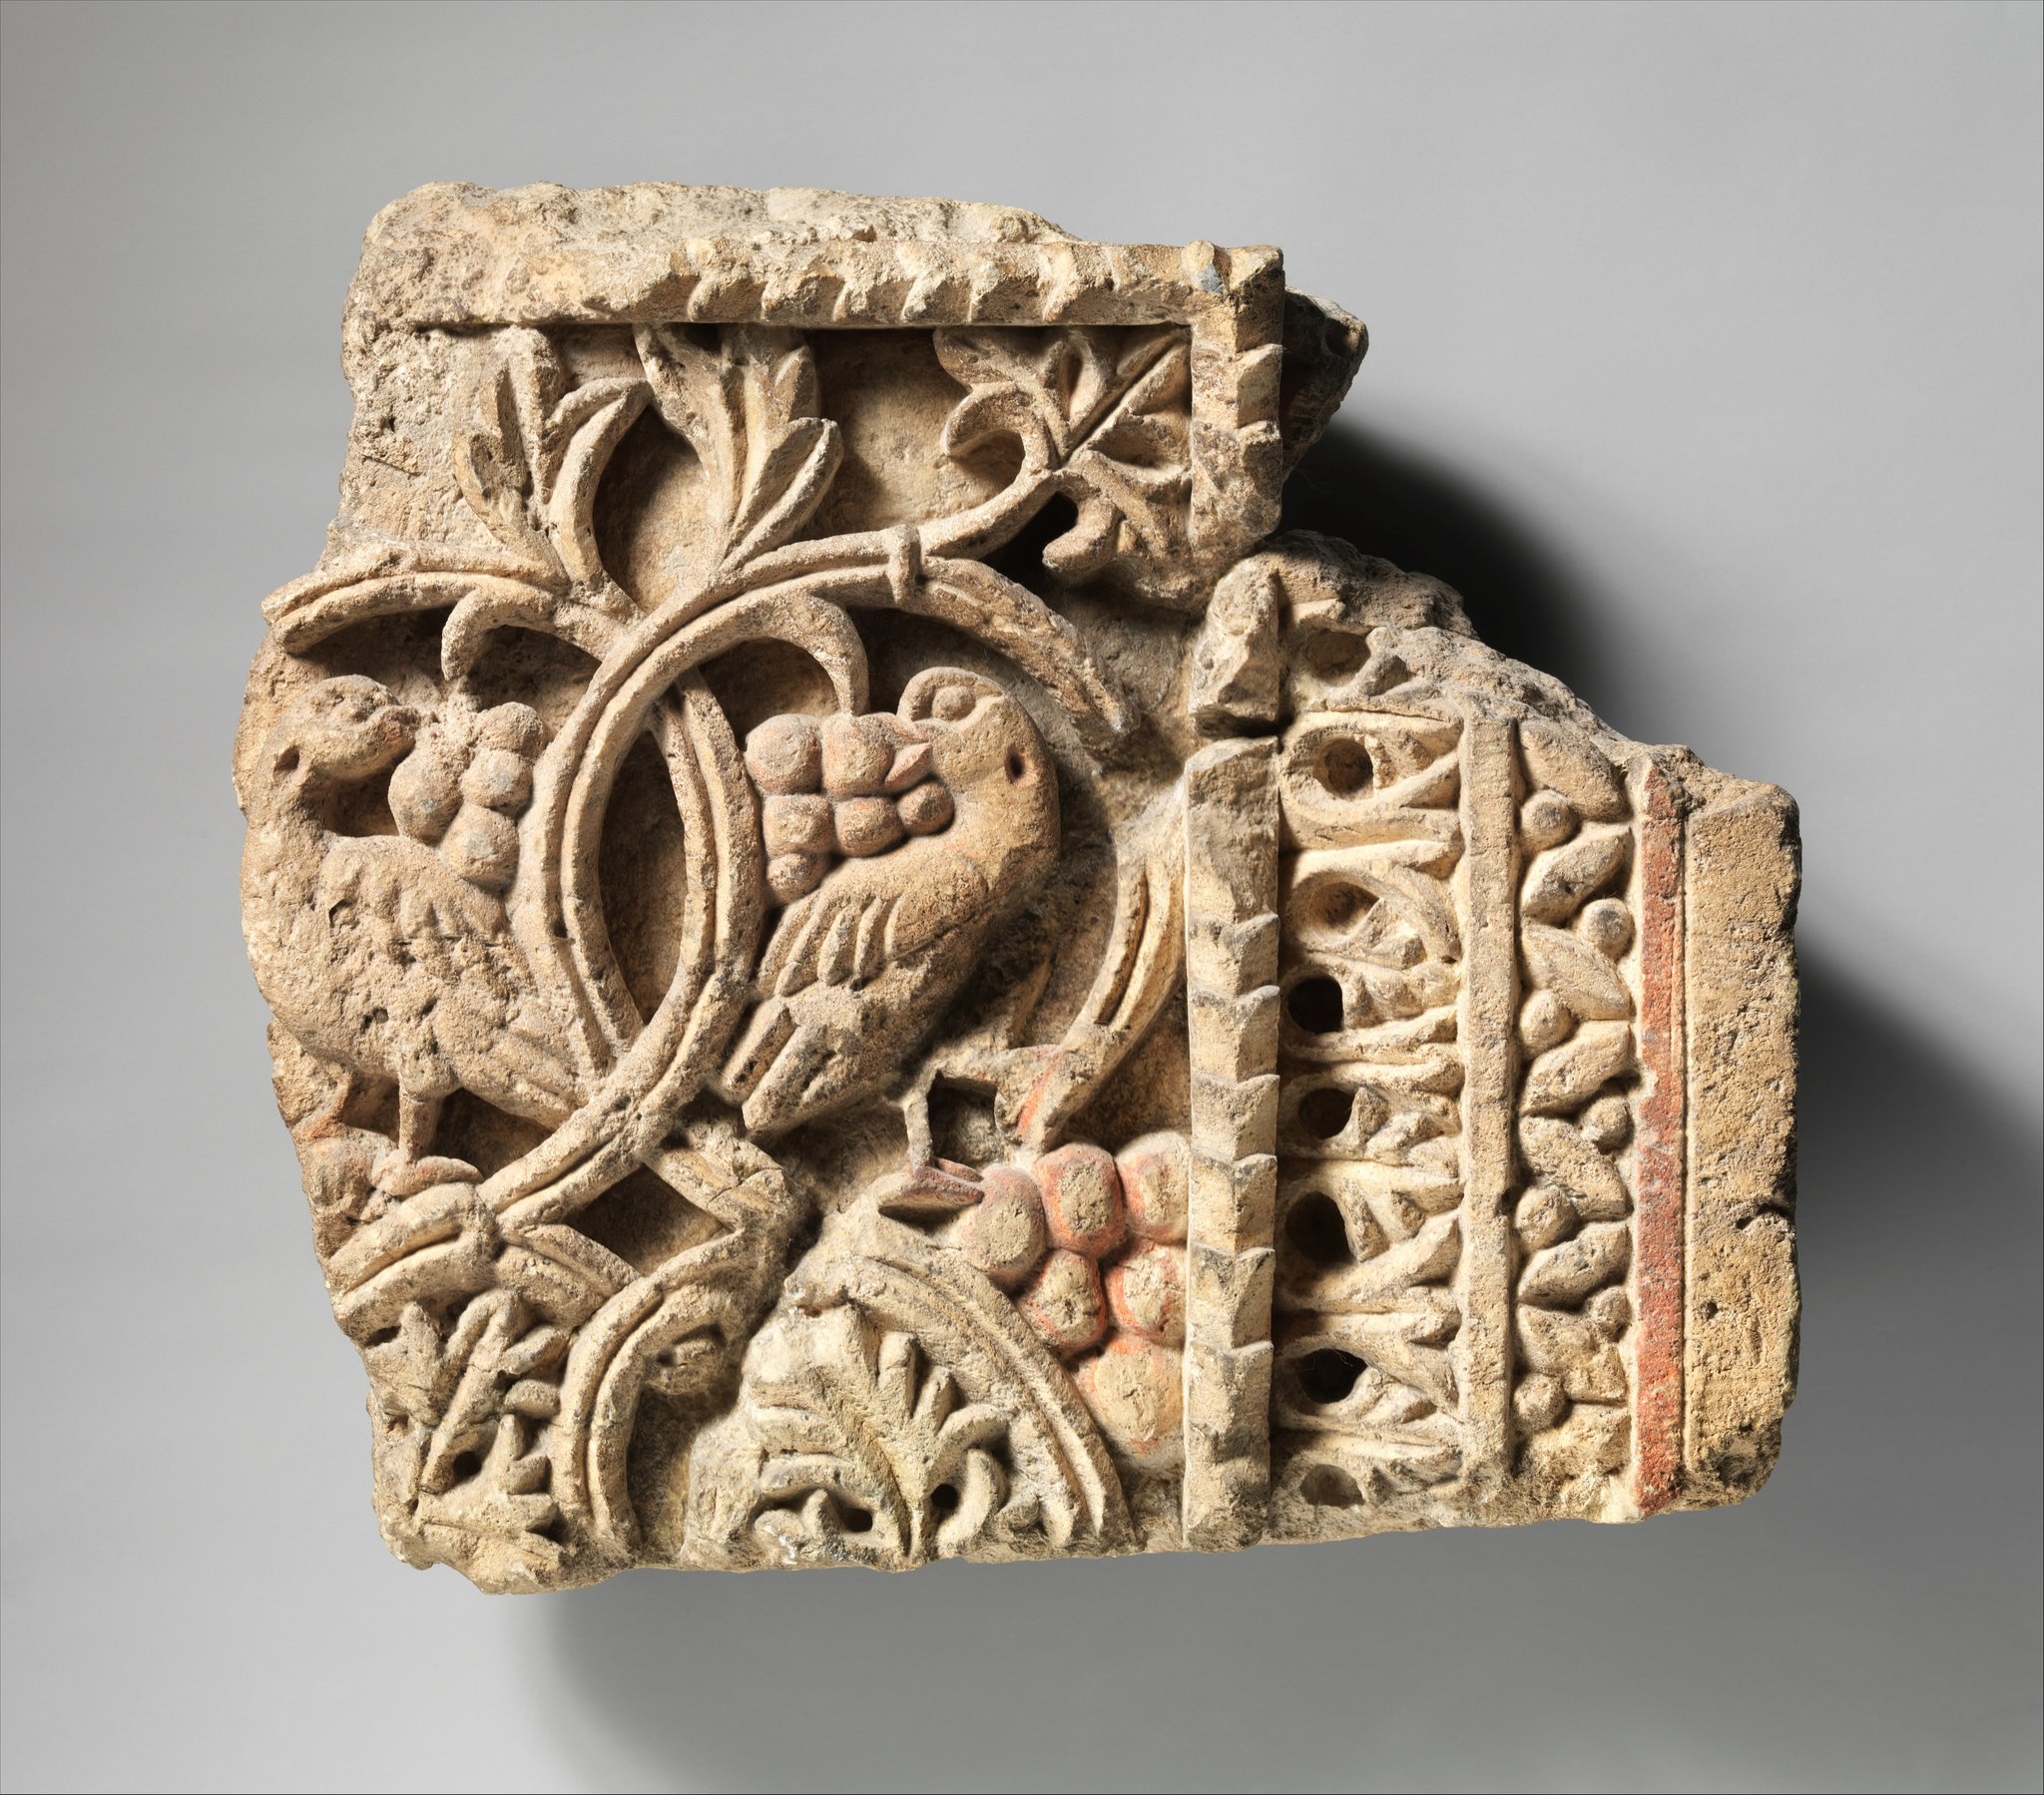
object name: screen fragment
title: Fragment from a Two-Sided Sanctuary Screen with Birds Eating Grapes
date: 401-600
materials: limestone, pigment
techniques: carving, relief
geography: egypt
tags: birds